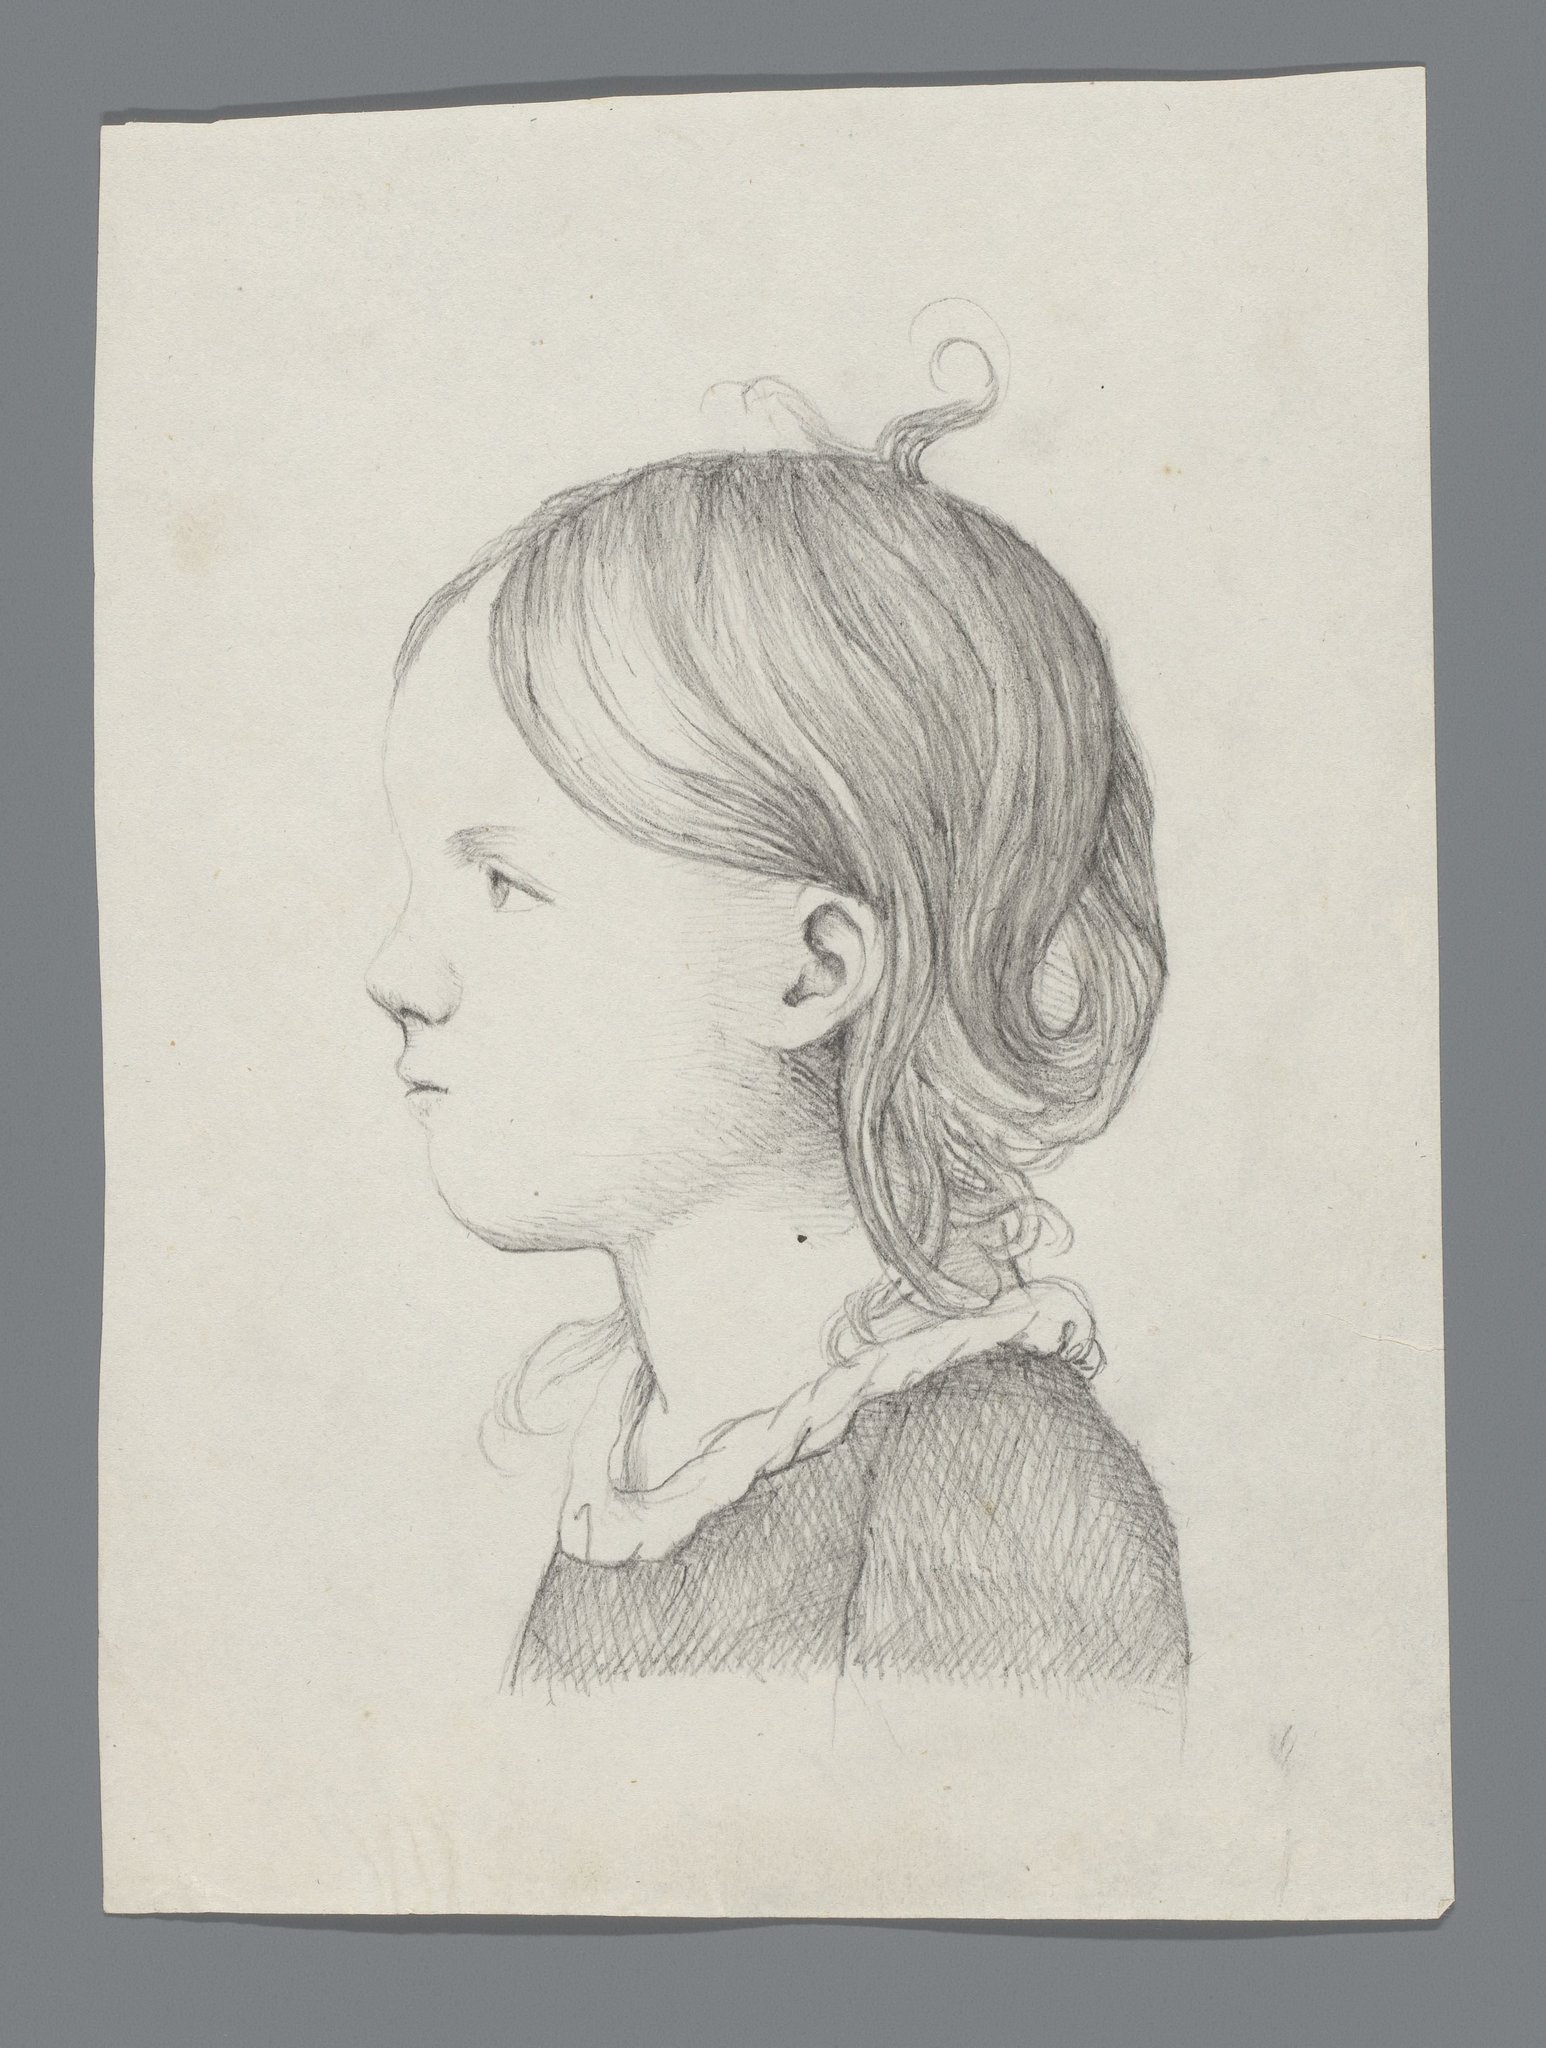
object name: drawing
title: Marie Eléonore Danville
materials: paper, pencil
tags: historical persons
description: De tekening van Humbert de Superville die als voorbeeld gediend heeft maakt deel uit van de collectie van het Prentenkabinet te Leiden.